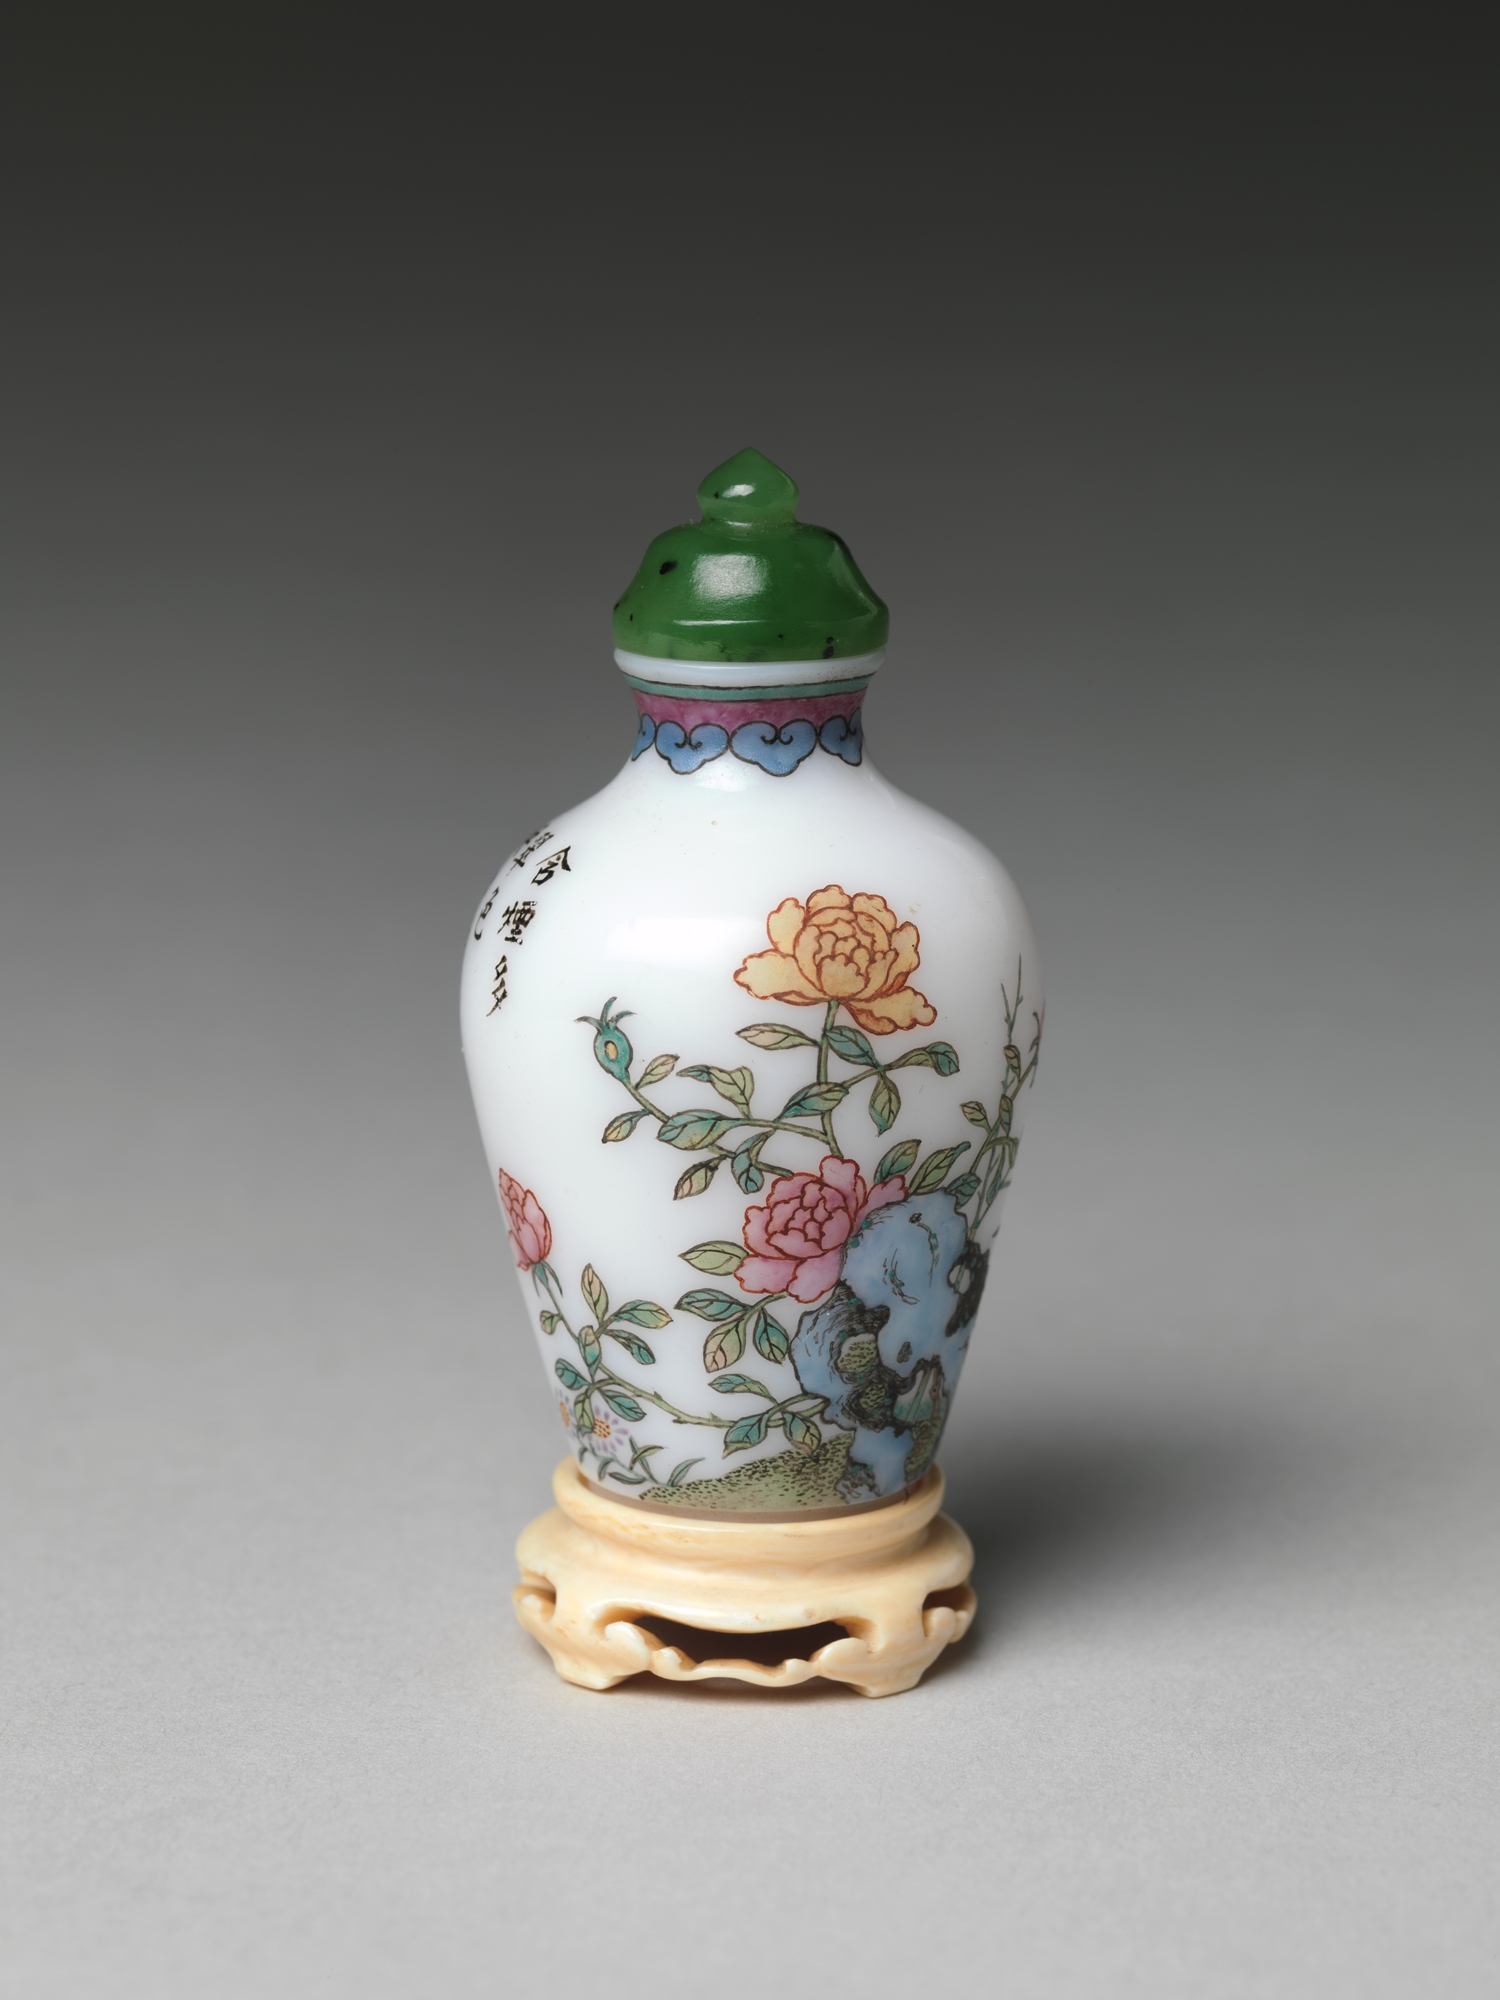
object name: snuff bottle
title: Snuff Bottle with Flowers and Rocks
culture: chinese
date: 1912-1949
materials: enamel, glass, jade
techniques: painting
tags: flowers